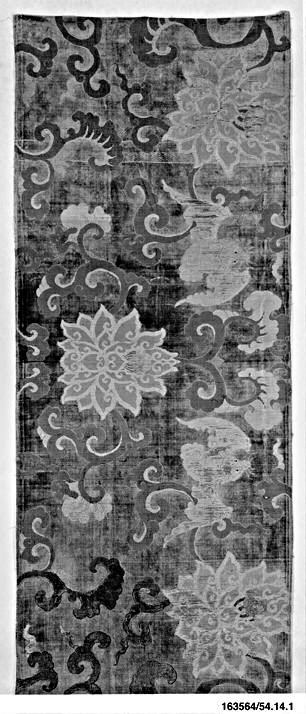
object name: panel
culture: chinese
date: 1601-1700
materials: silk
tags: flowers